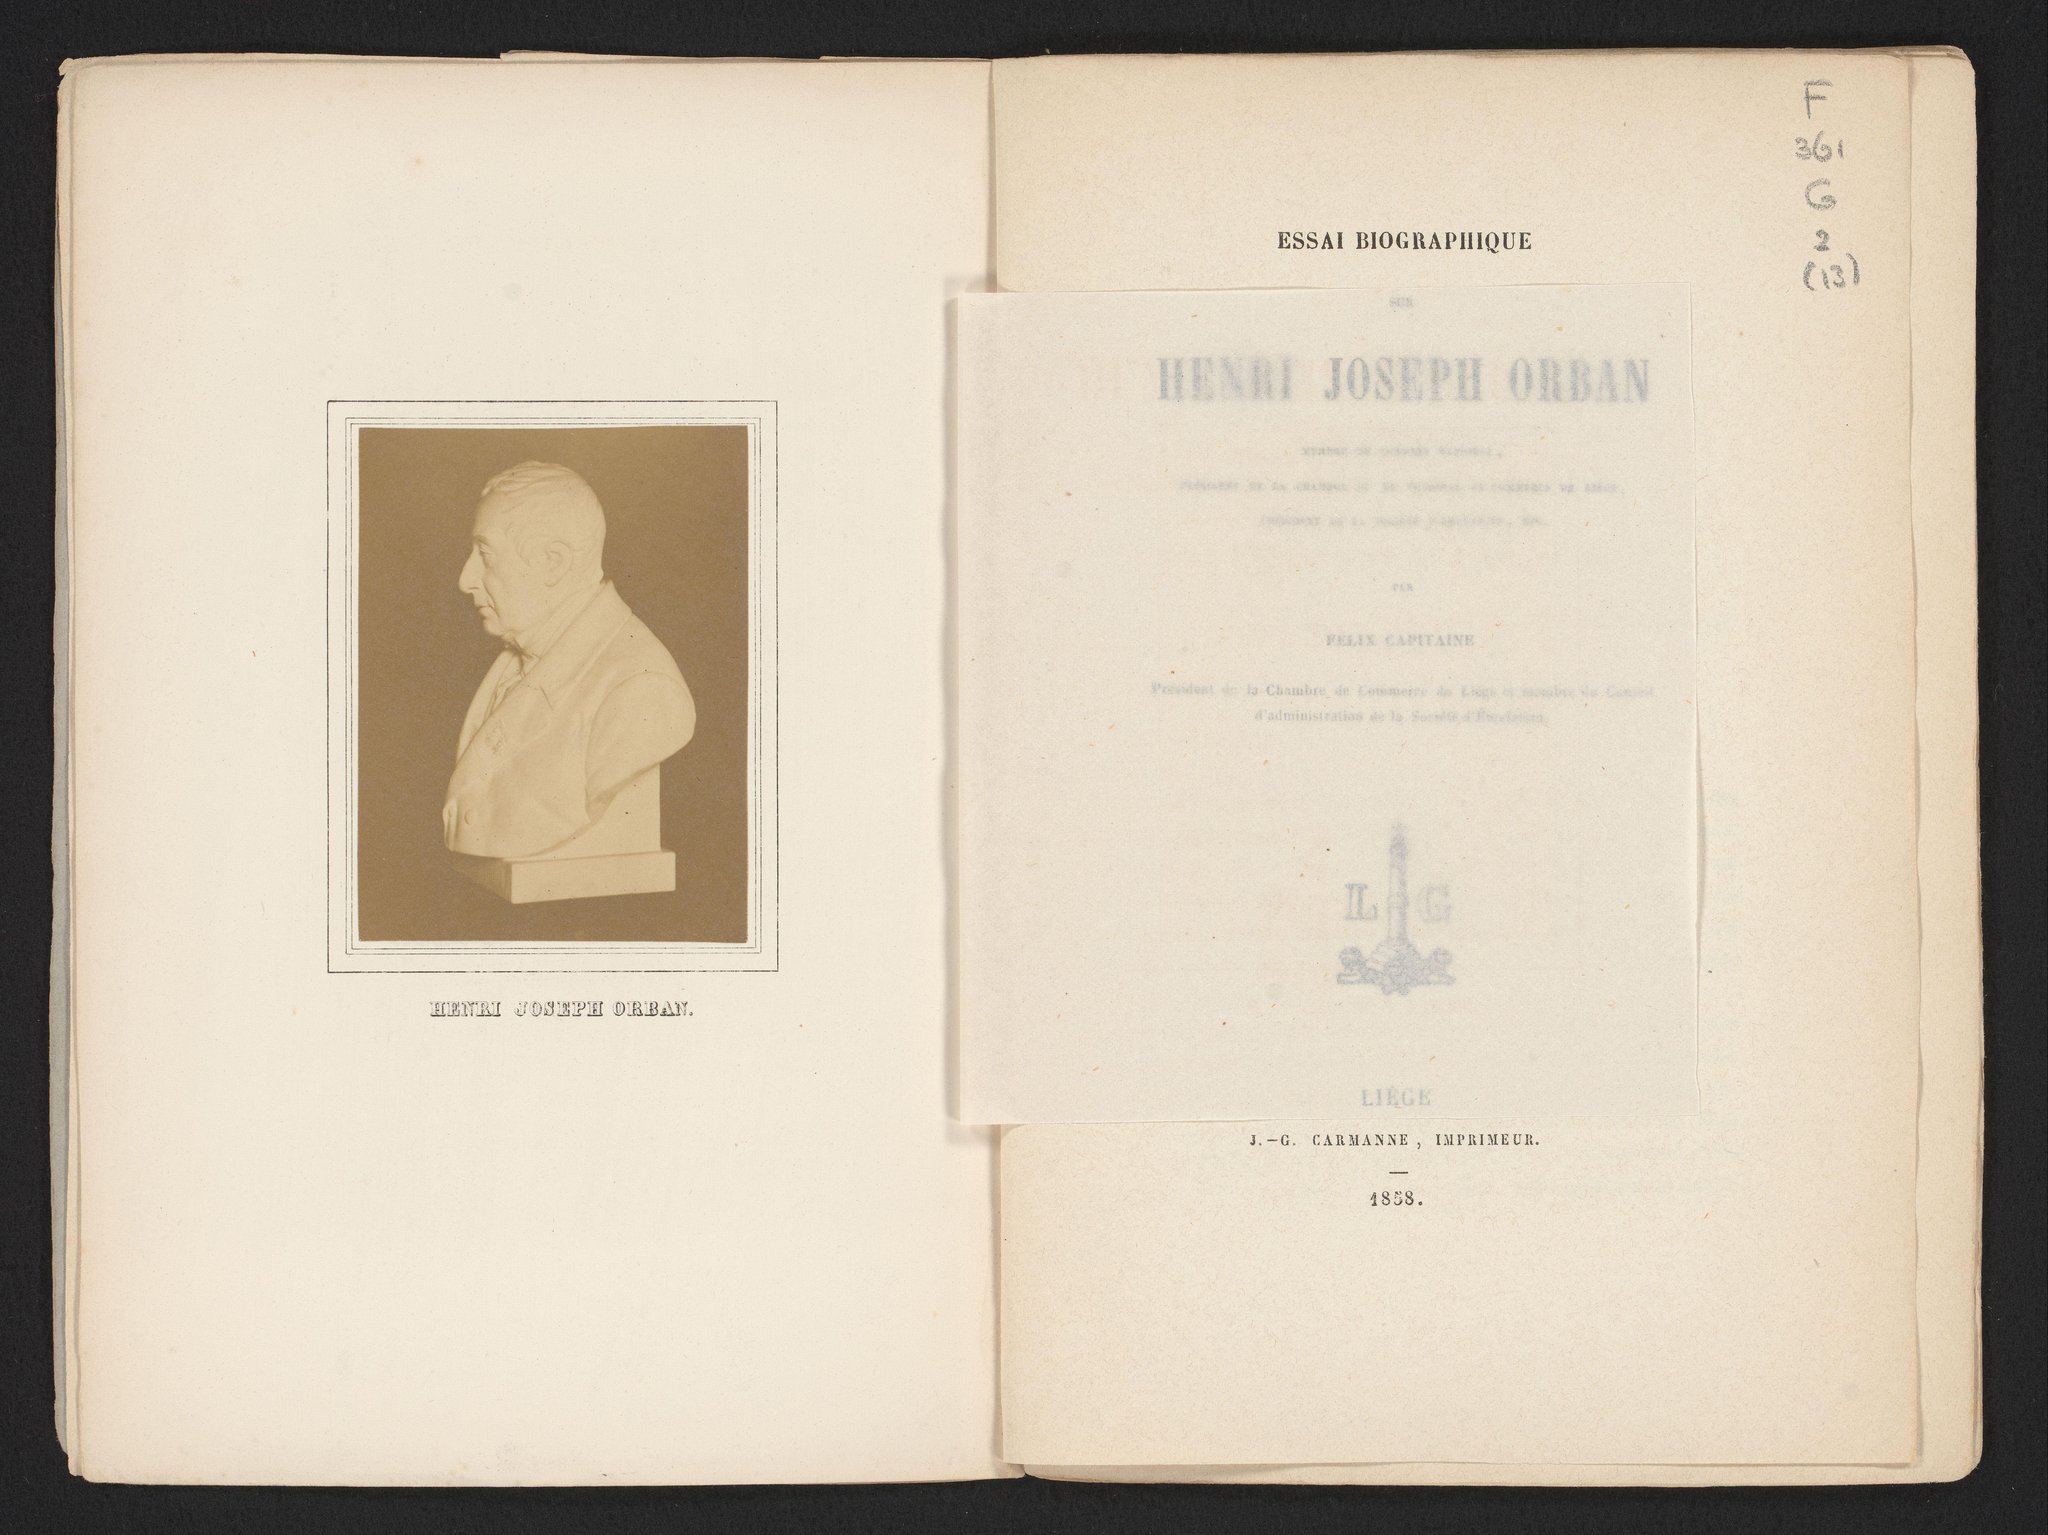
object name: photograph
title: Buste van Henri Joseph Orban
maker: Anonymous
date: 1853-1858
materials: photographic support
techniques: albumen print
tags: sculpture